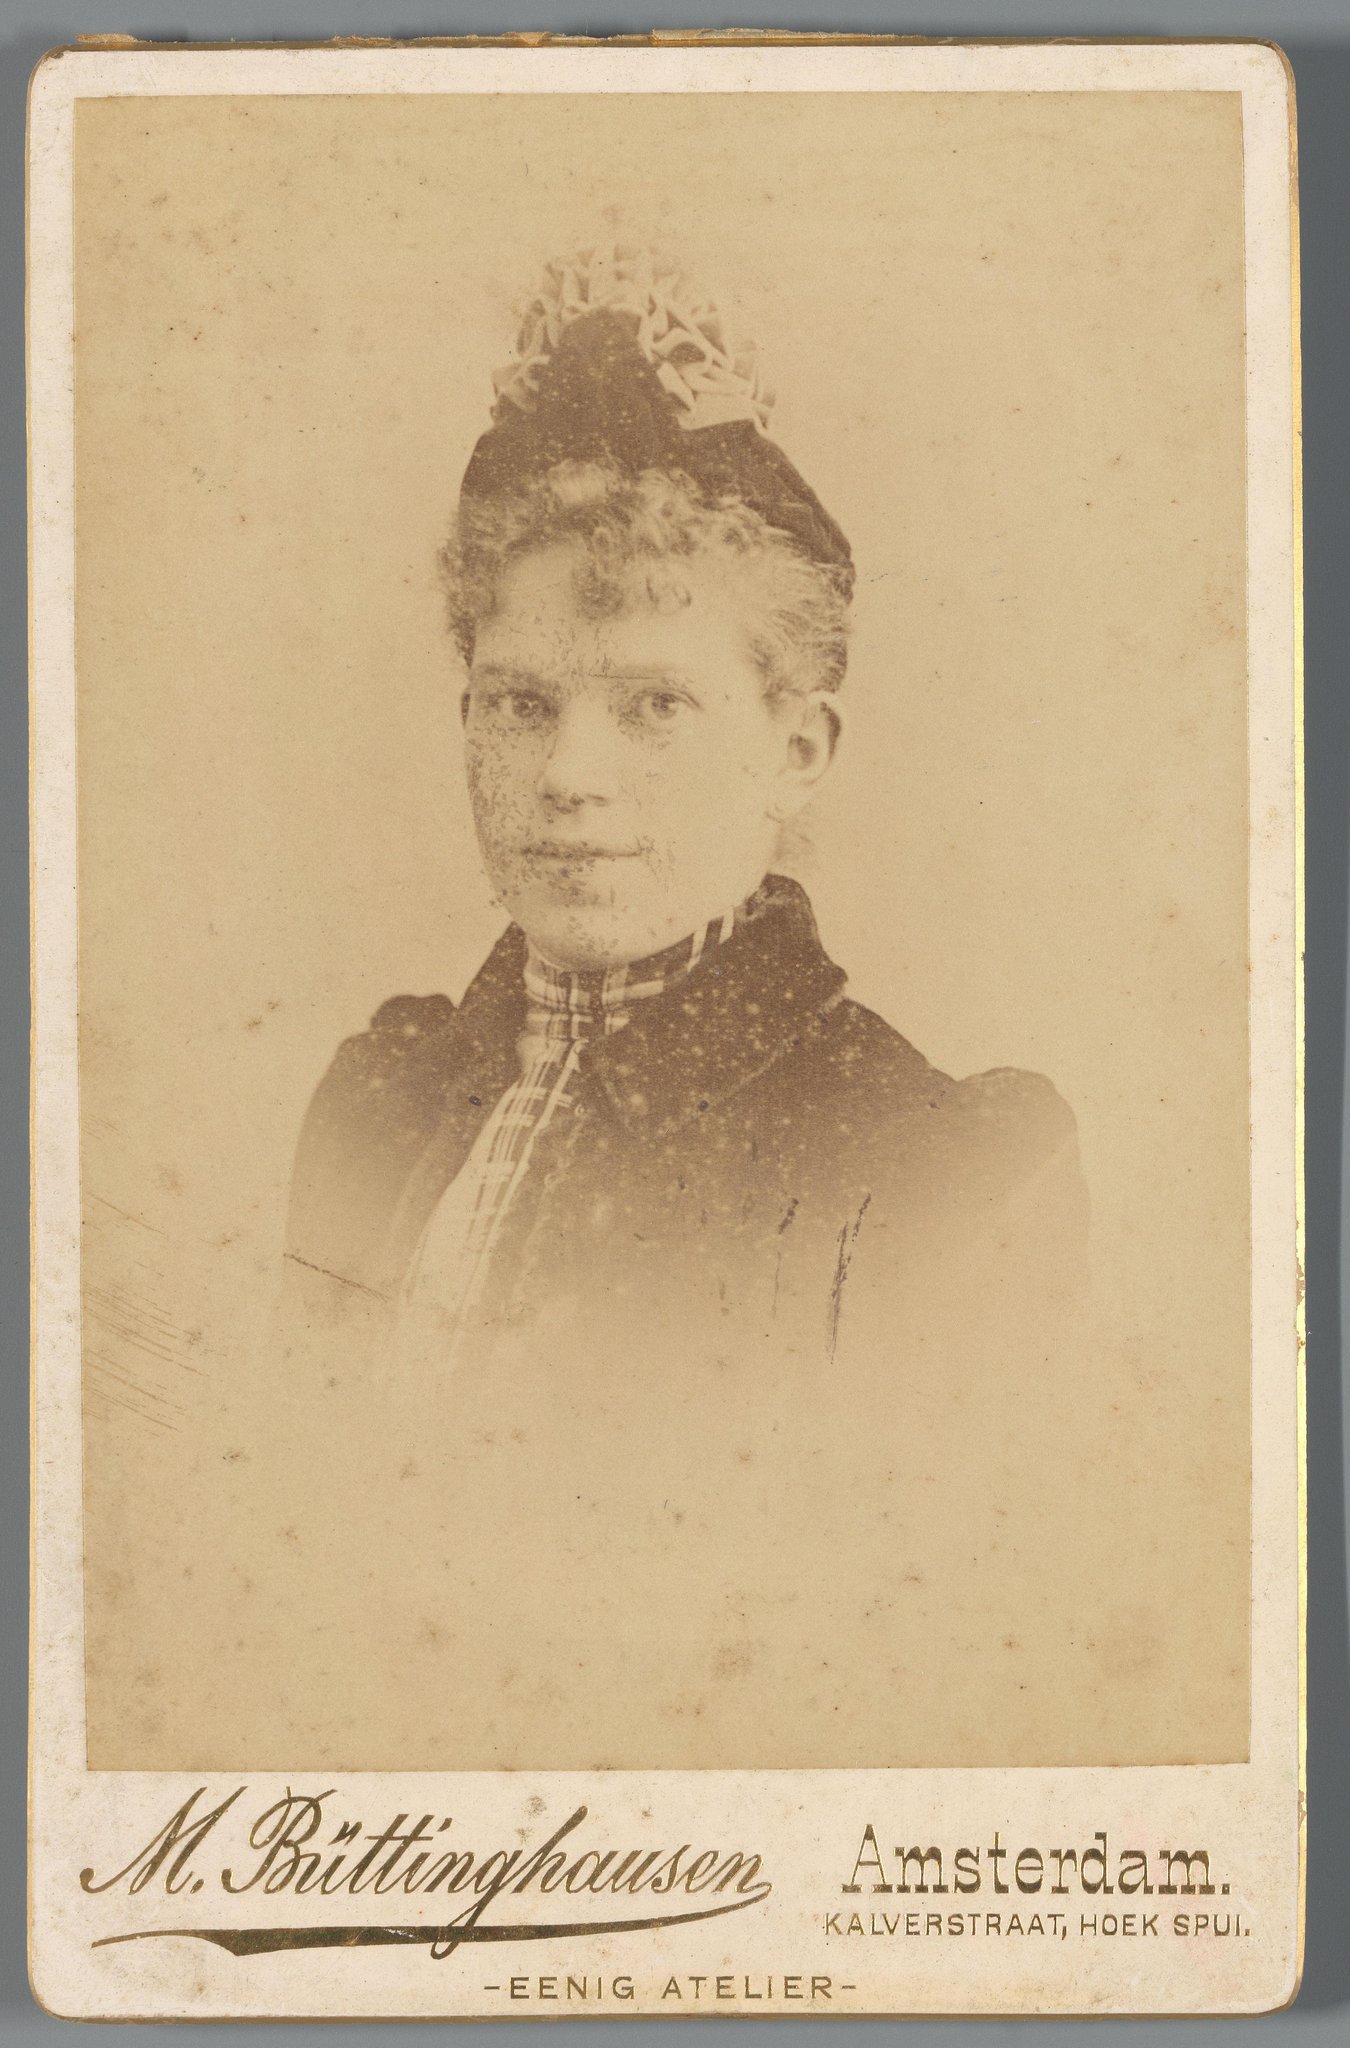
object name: cabinet photograph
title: Portret van Emilie van den Berg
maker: max büttinghausen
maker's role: fotograaf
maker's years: 1847-1906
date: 1898-1910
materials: cardboard, photographic support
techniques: albumen print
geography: spui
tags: batavia, emilie albertine onnen-van den berg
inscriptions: inscription: ‘M. Büttinghausen Amsterdam. / KALVERSTRAAT, HOEK SPUI. / -EENIG ATELIER-’